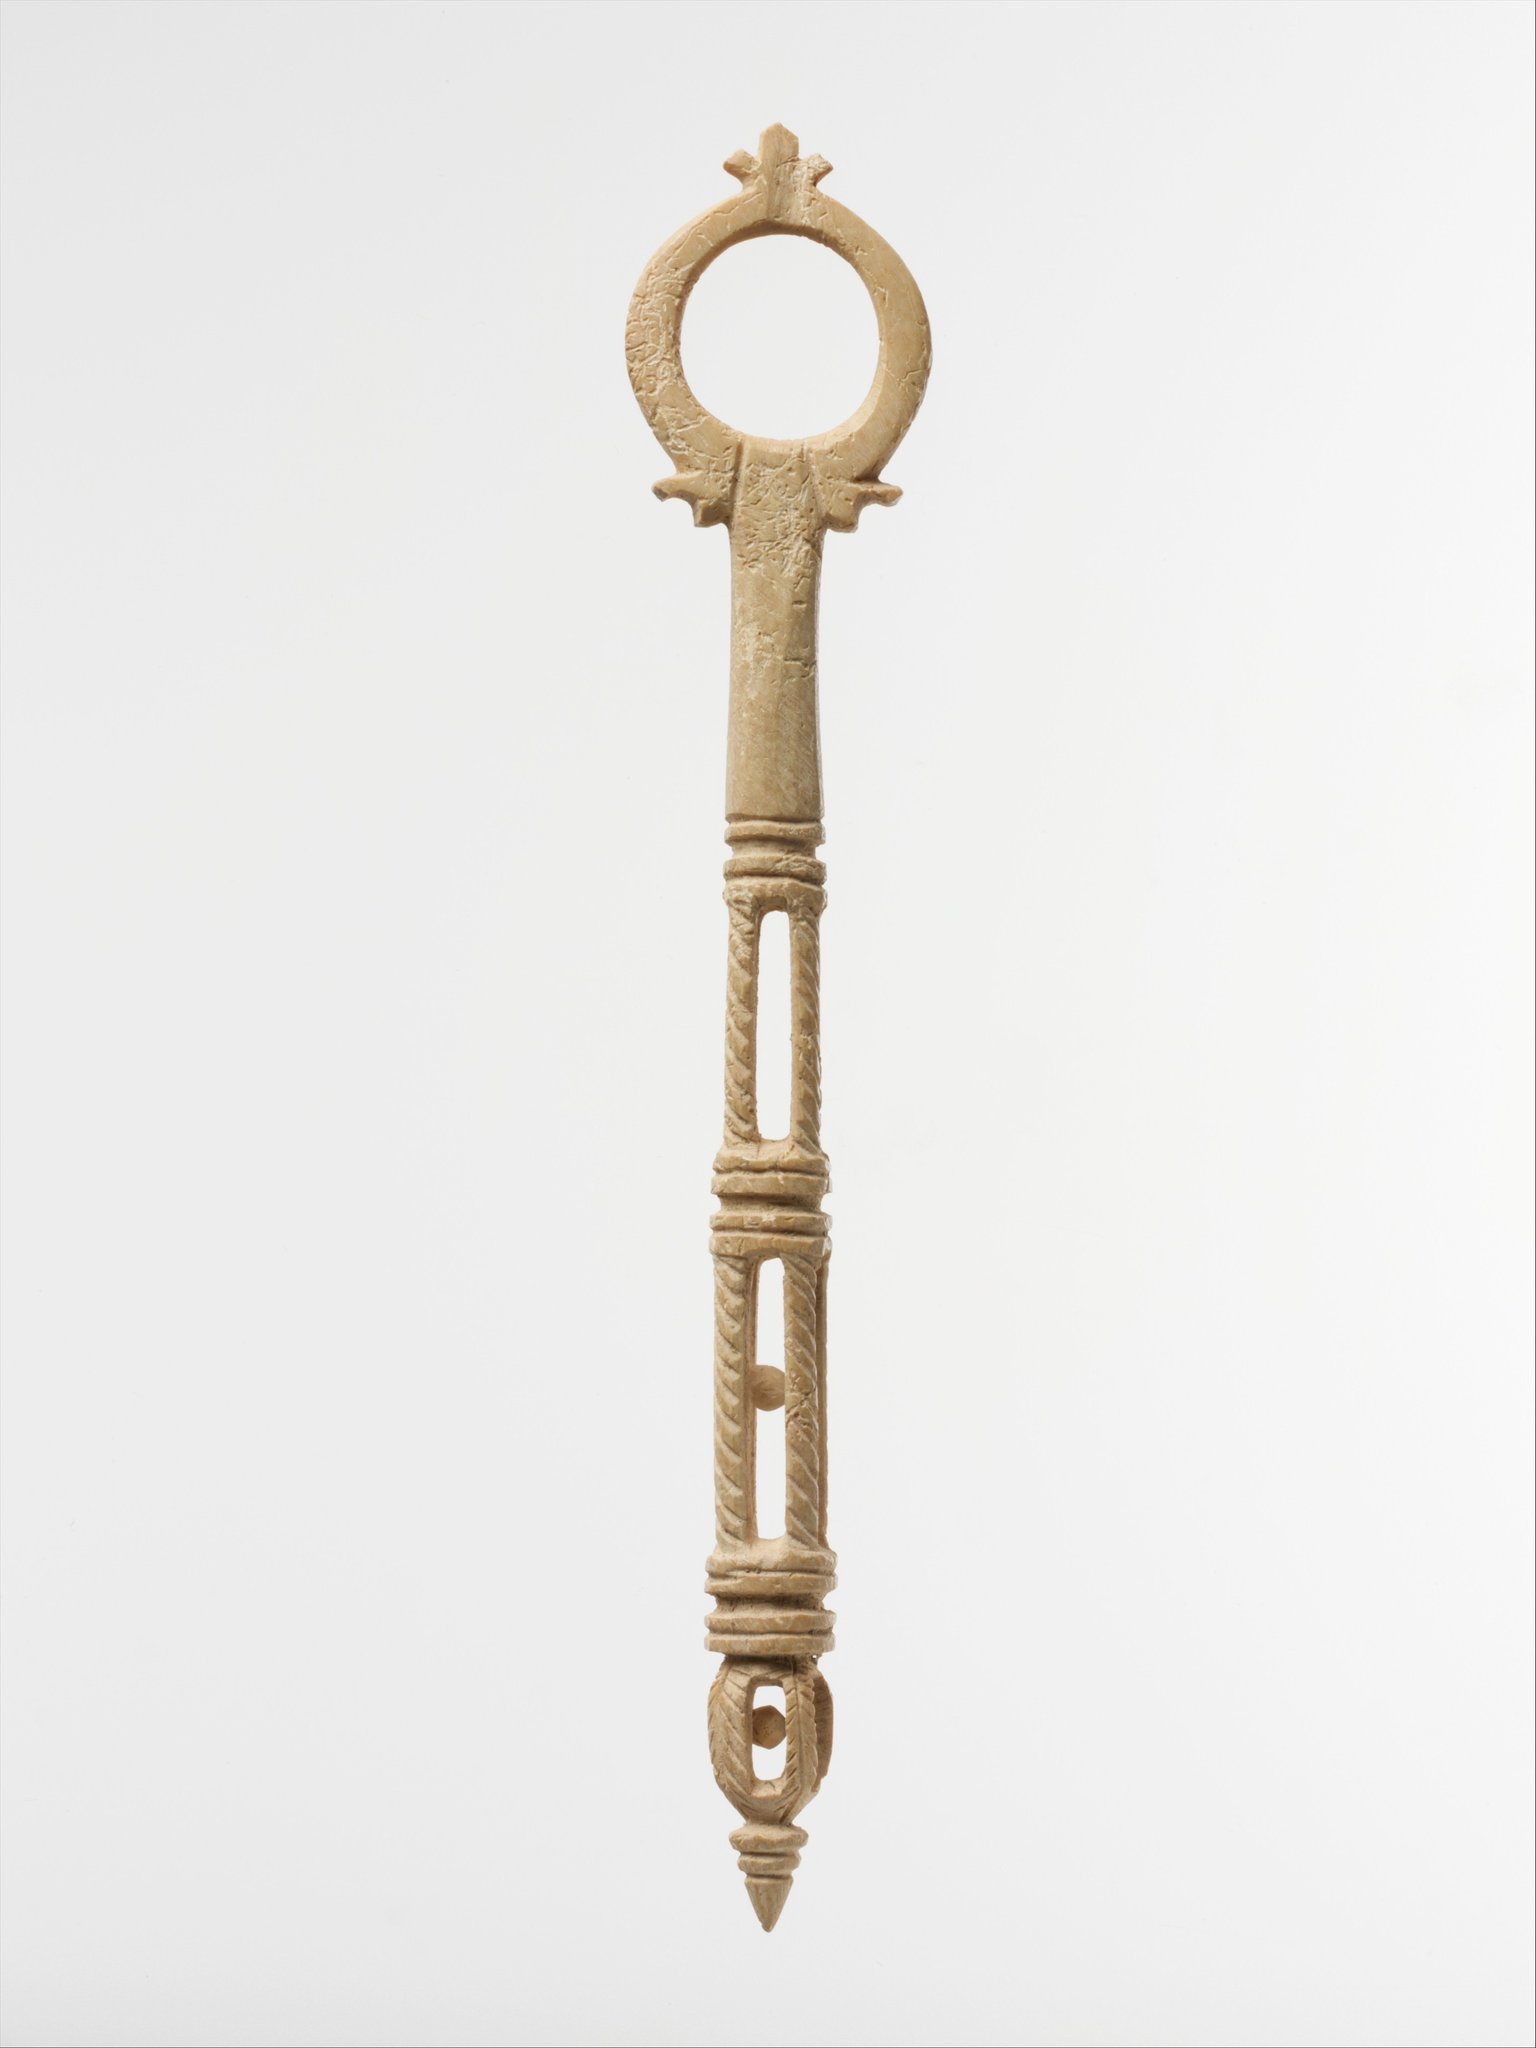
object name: stylus or rattle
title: Bone implement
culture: roman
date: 101-300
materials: bone